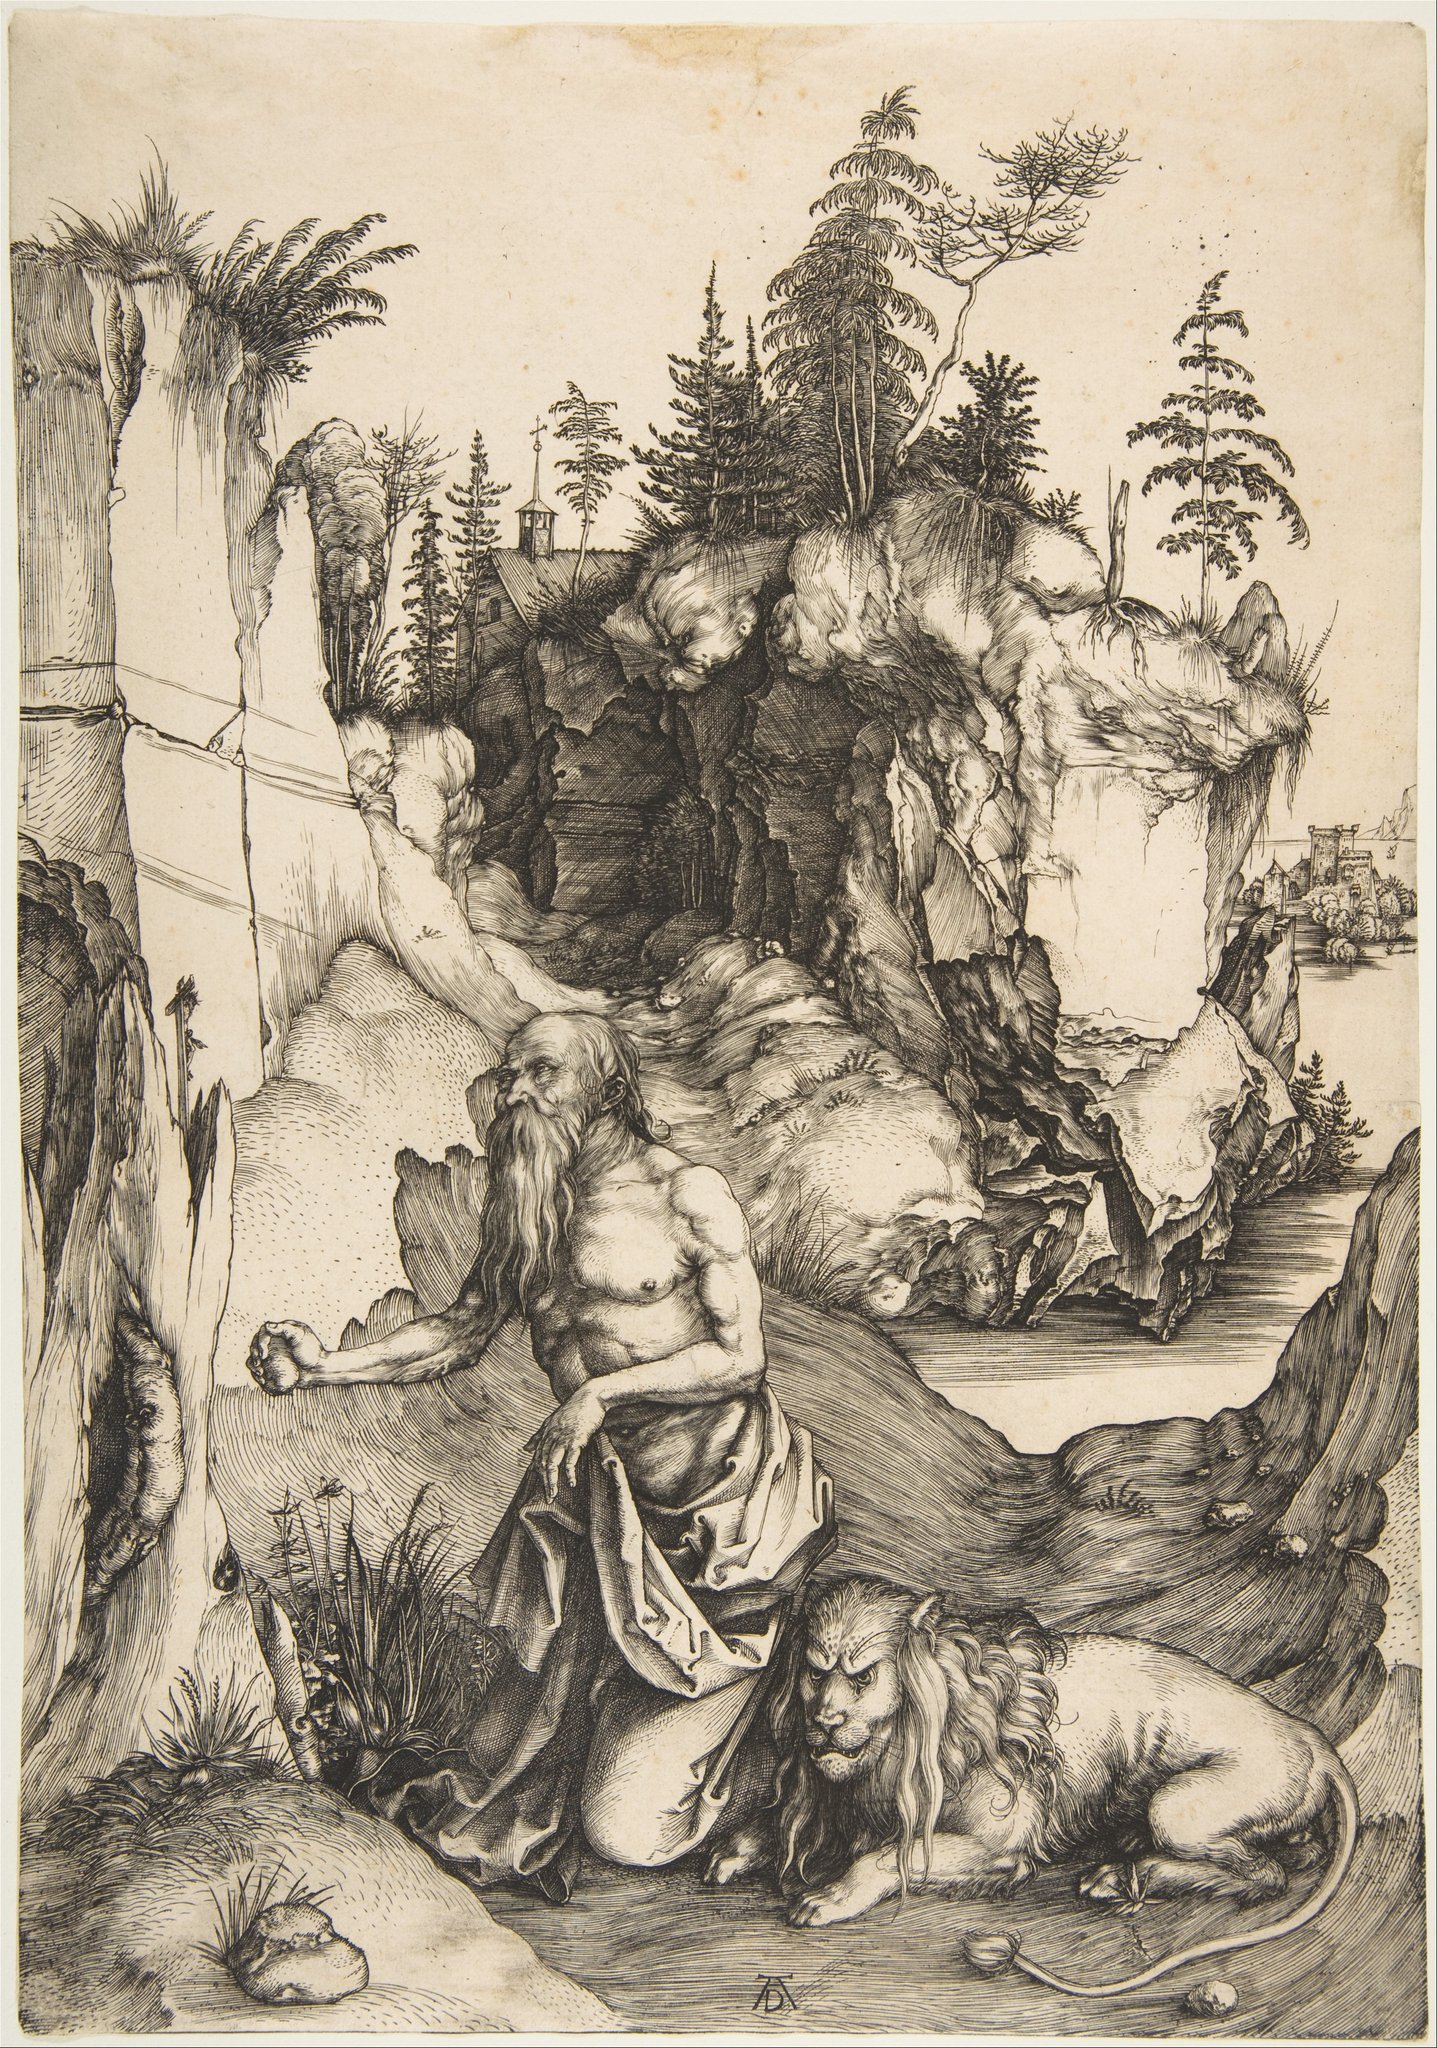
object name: print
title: Saint Jerome Penitent in the Wilderness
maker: albrecht dürer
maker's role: artist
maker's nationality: german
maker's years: 1471-1528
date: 1496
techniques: engraving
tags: lions,trees,saint jerome